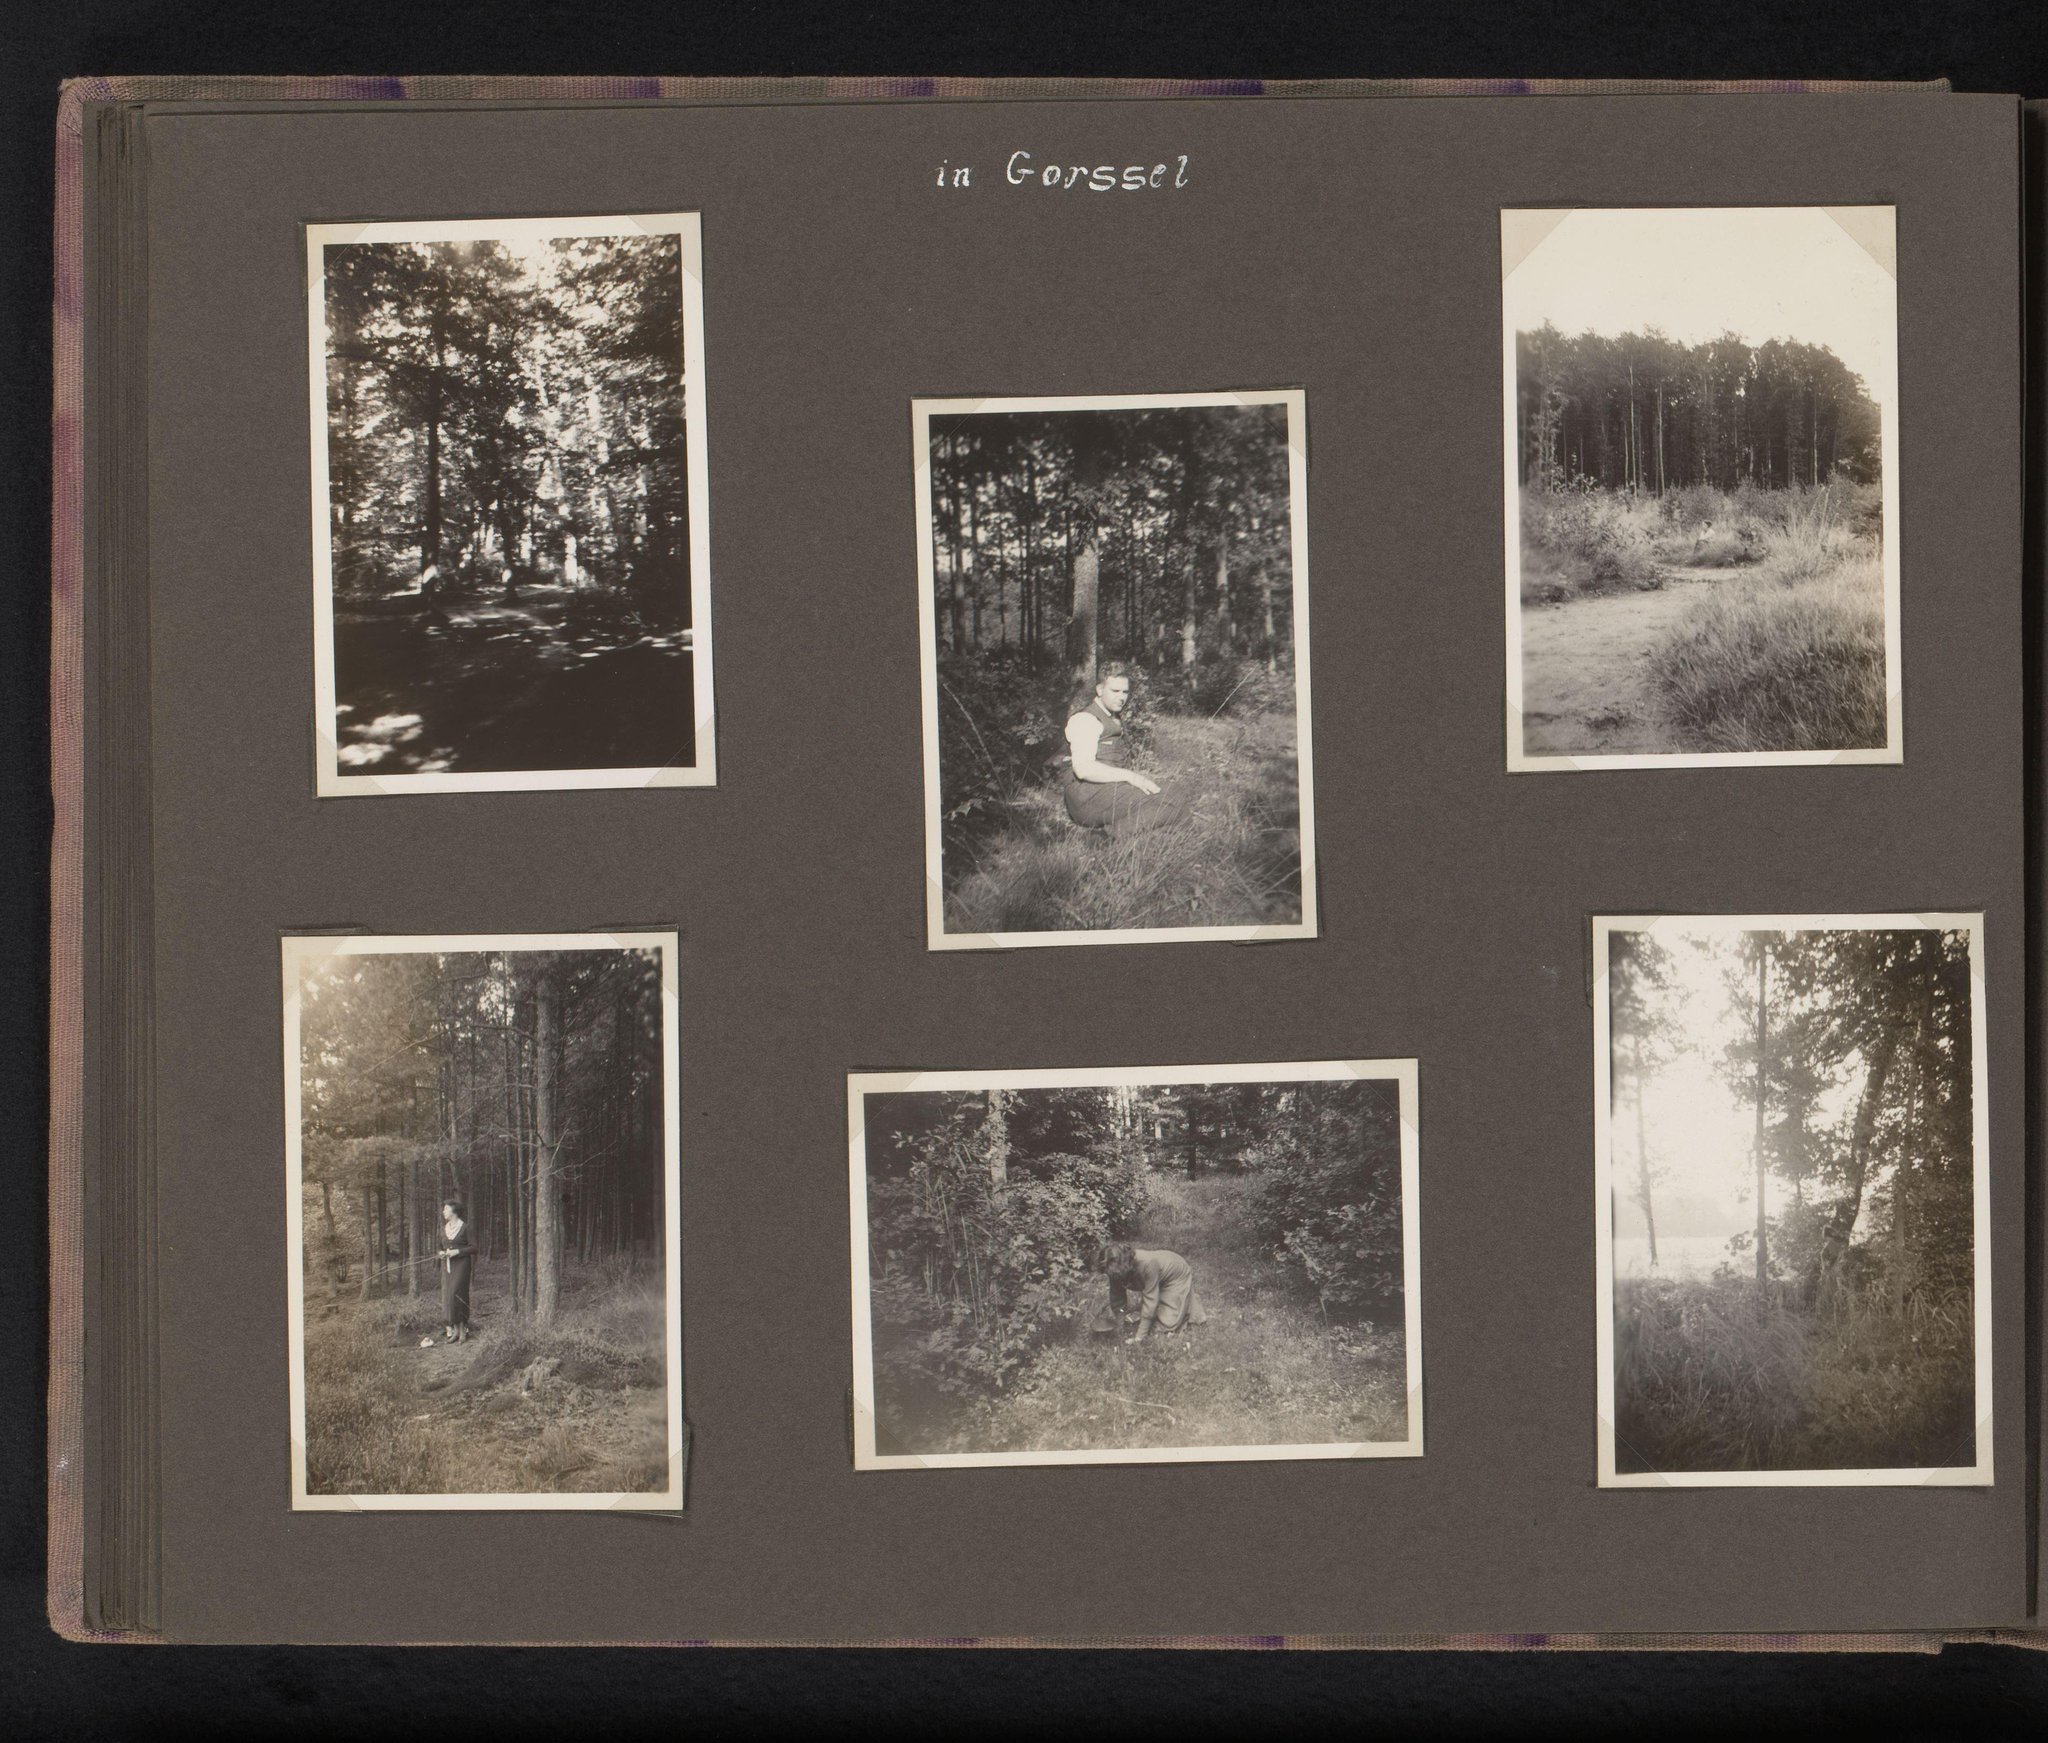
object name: photograph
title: Echtpaar Berti Hoppe en Herman Besselaar in het bos te Gorssel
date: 1909-1932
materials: cardboard, paper, photographic support, plastic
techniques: gelatin silver print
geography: gorssel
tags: historical persons - bb - woman, historical persons, forest, wood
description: Vijf foto's gemaakt tijdens hun vakantie in Oost-Nederland in september 1932. Deze pagina maakt deel uit van een album.